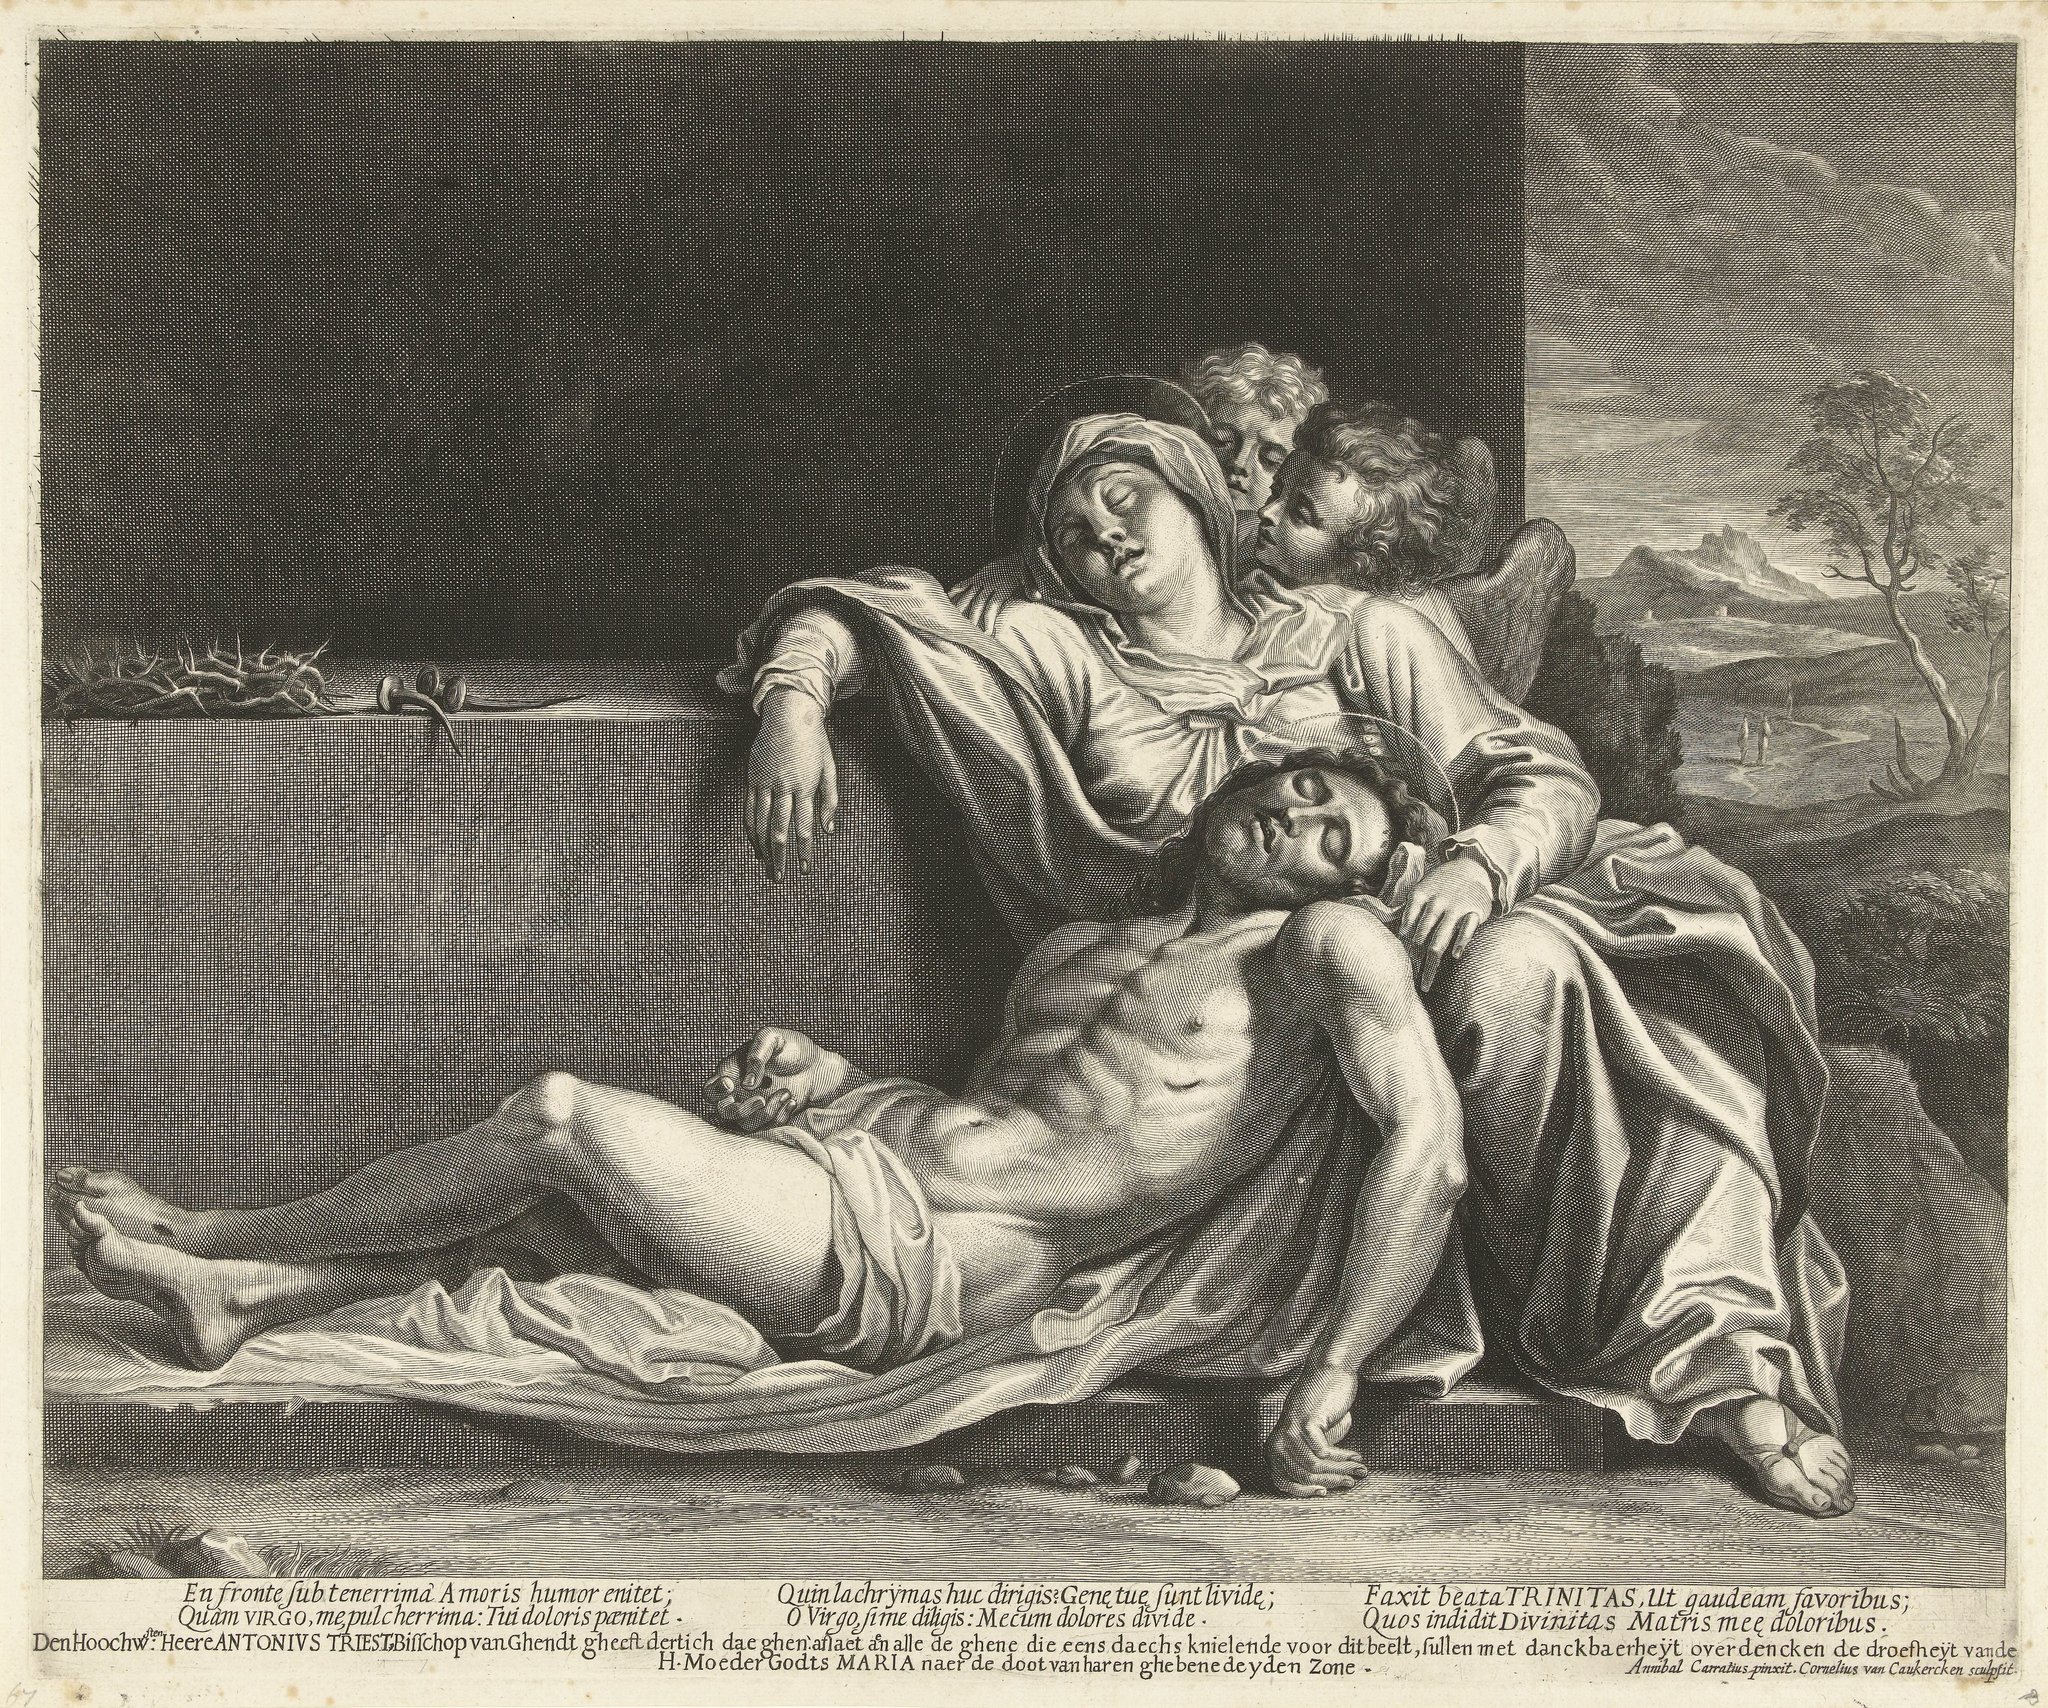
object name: print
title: Maria met het lichaam van Christus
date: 1640-1680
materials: paper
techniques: engraving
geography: southern netherlands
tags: 'pietà ', 'vesperbild', 'marienklage' (no others present): christ, either with or without crown of thorns, mourned by mary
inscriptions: collector's mark: Lugt 240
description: Maria leunt tegen een steen aan en slaapt, het lichaam van Christus ligt naast haar. Op de steenblok liggen Christus' doornenkroon en de spijkers. Onder de voorstelling een vers in het Latijn en een aflaat door de bisschop van Gent Antonius van Triest.